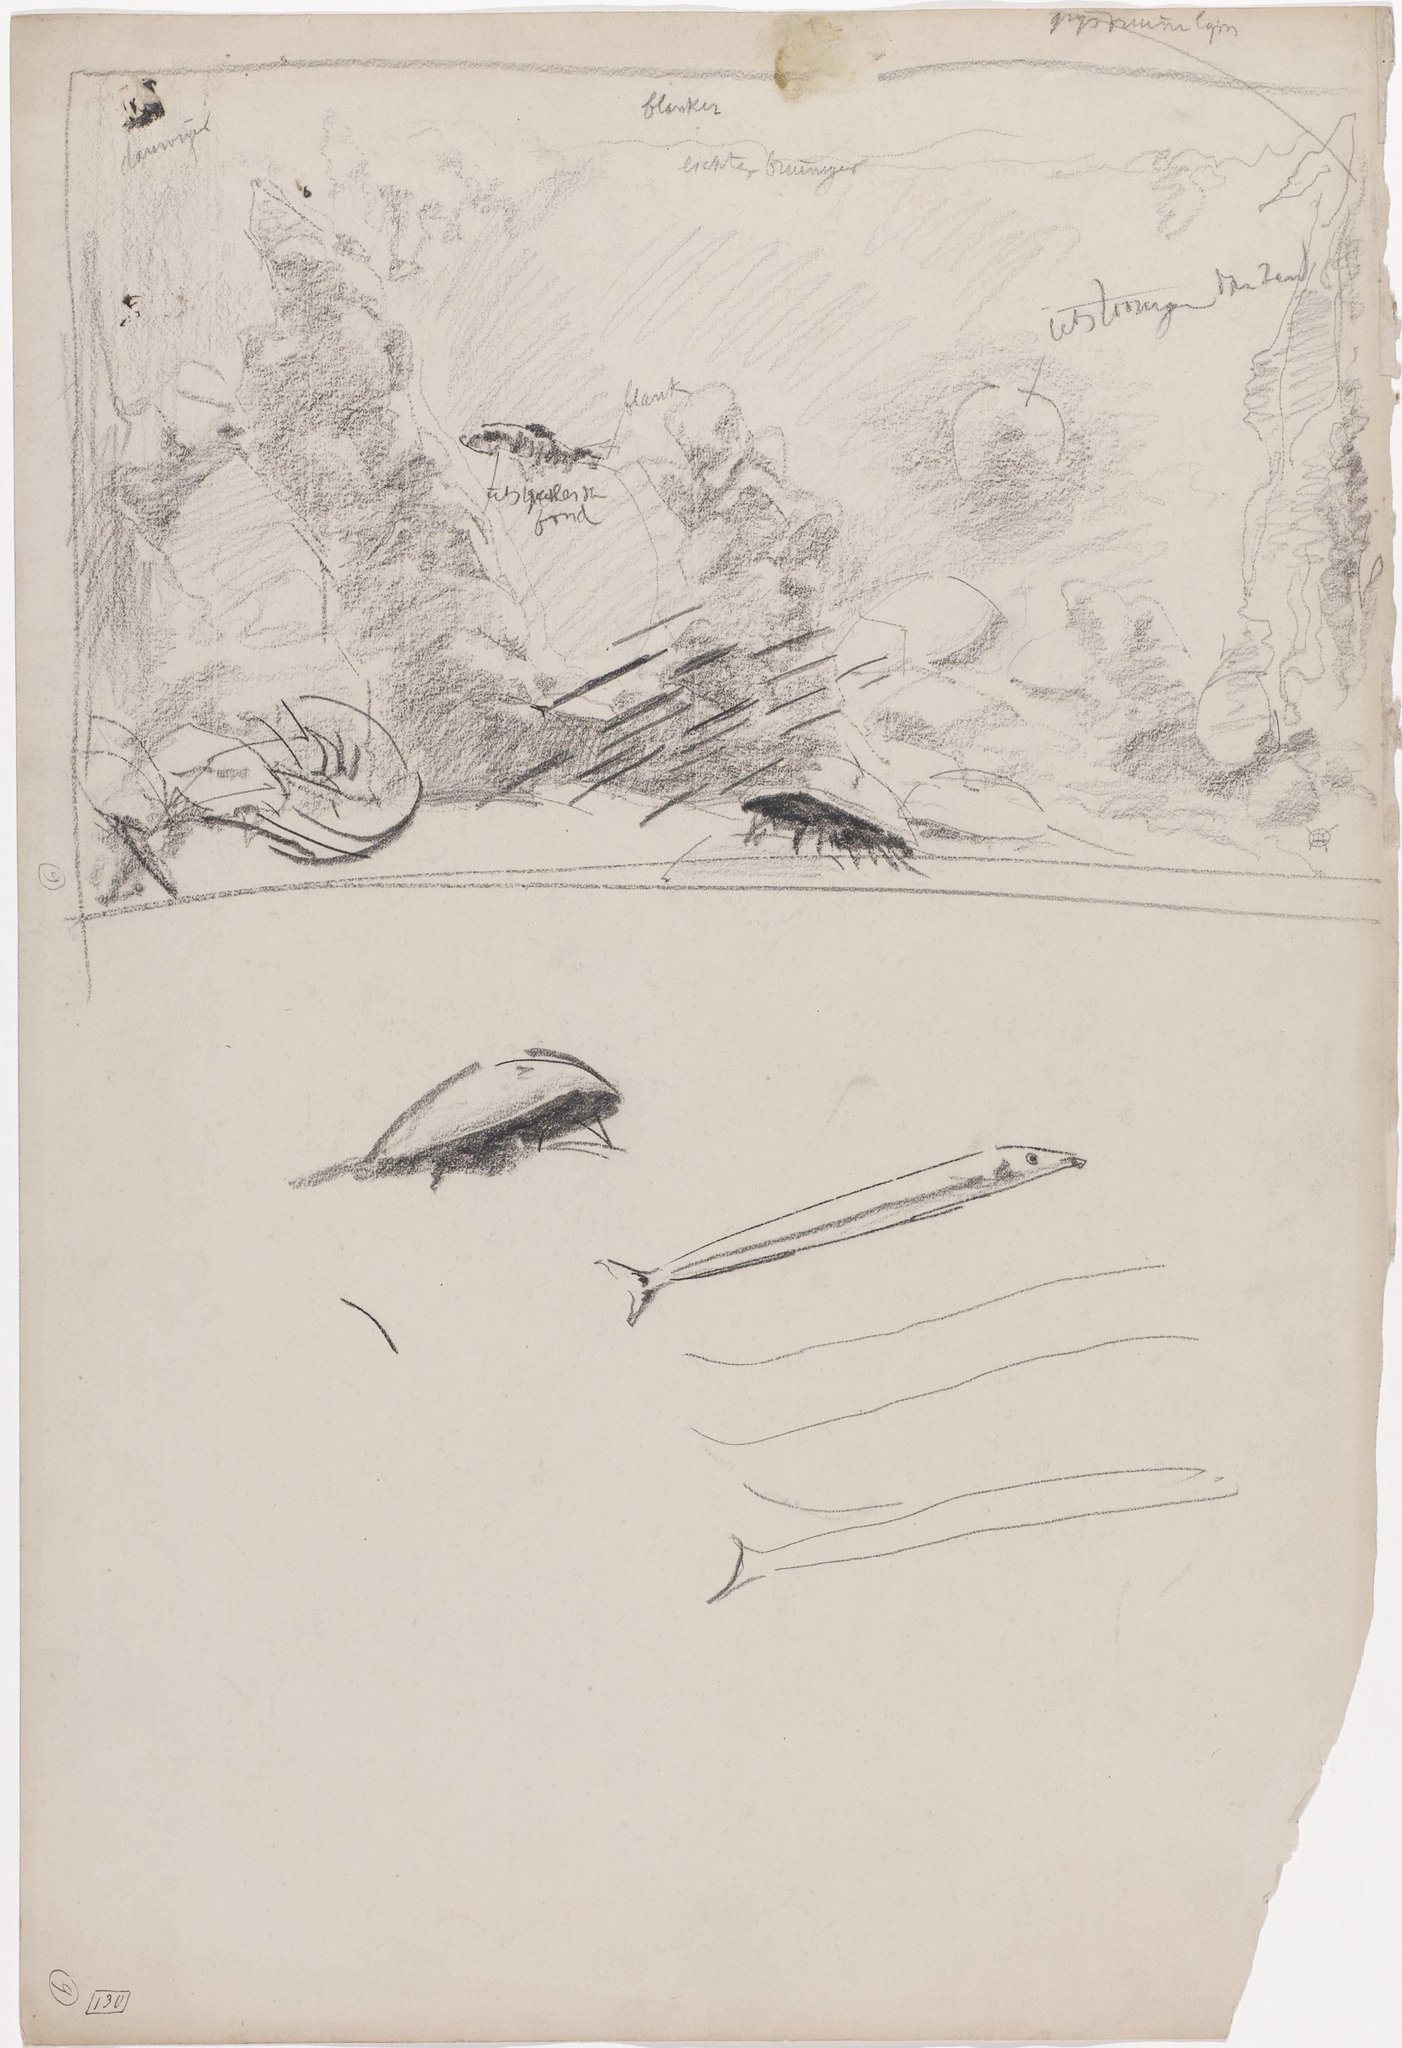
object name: drawing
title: Schets van een aquarium met vissen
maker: gerrit willem dijsselhof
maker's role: designer, draughtsman, print maker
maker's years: 1866-1924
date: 1876-1924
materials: chalk, paper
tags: aquarium, fishes